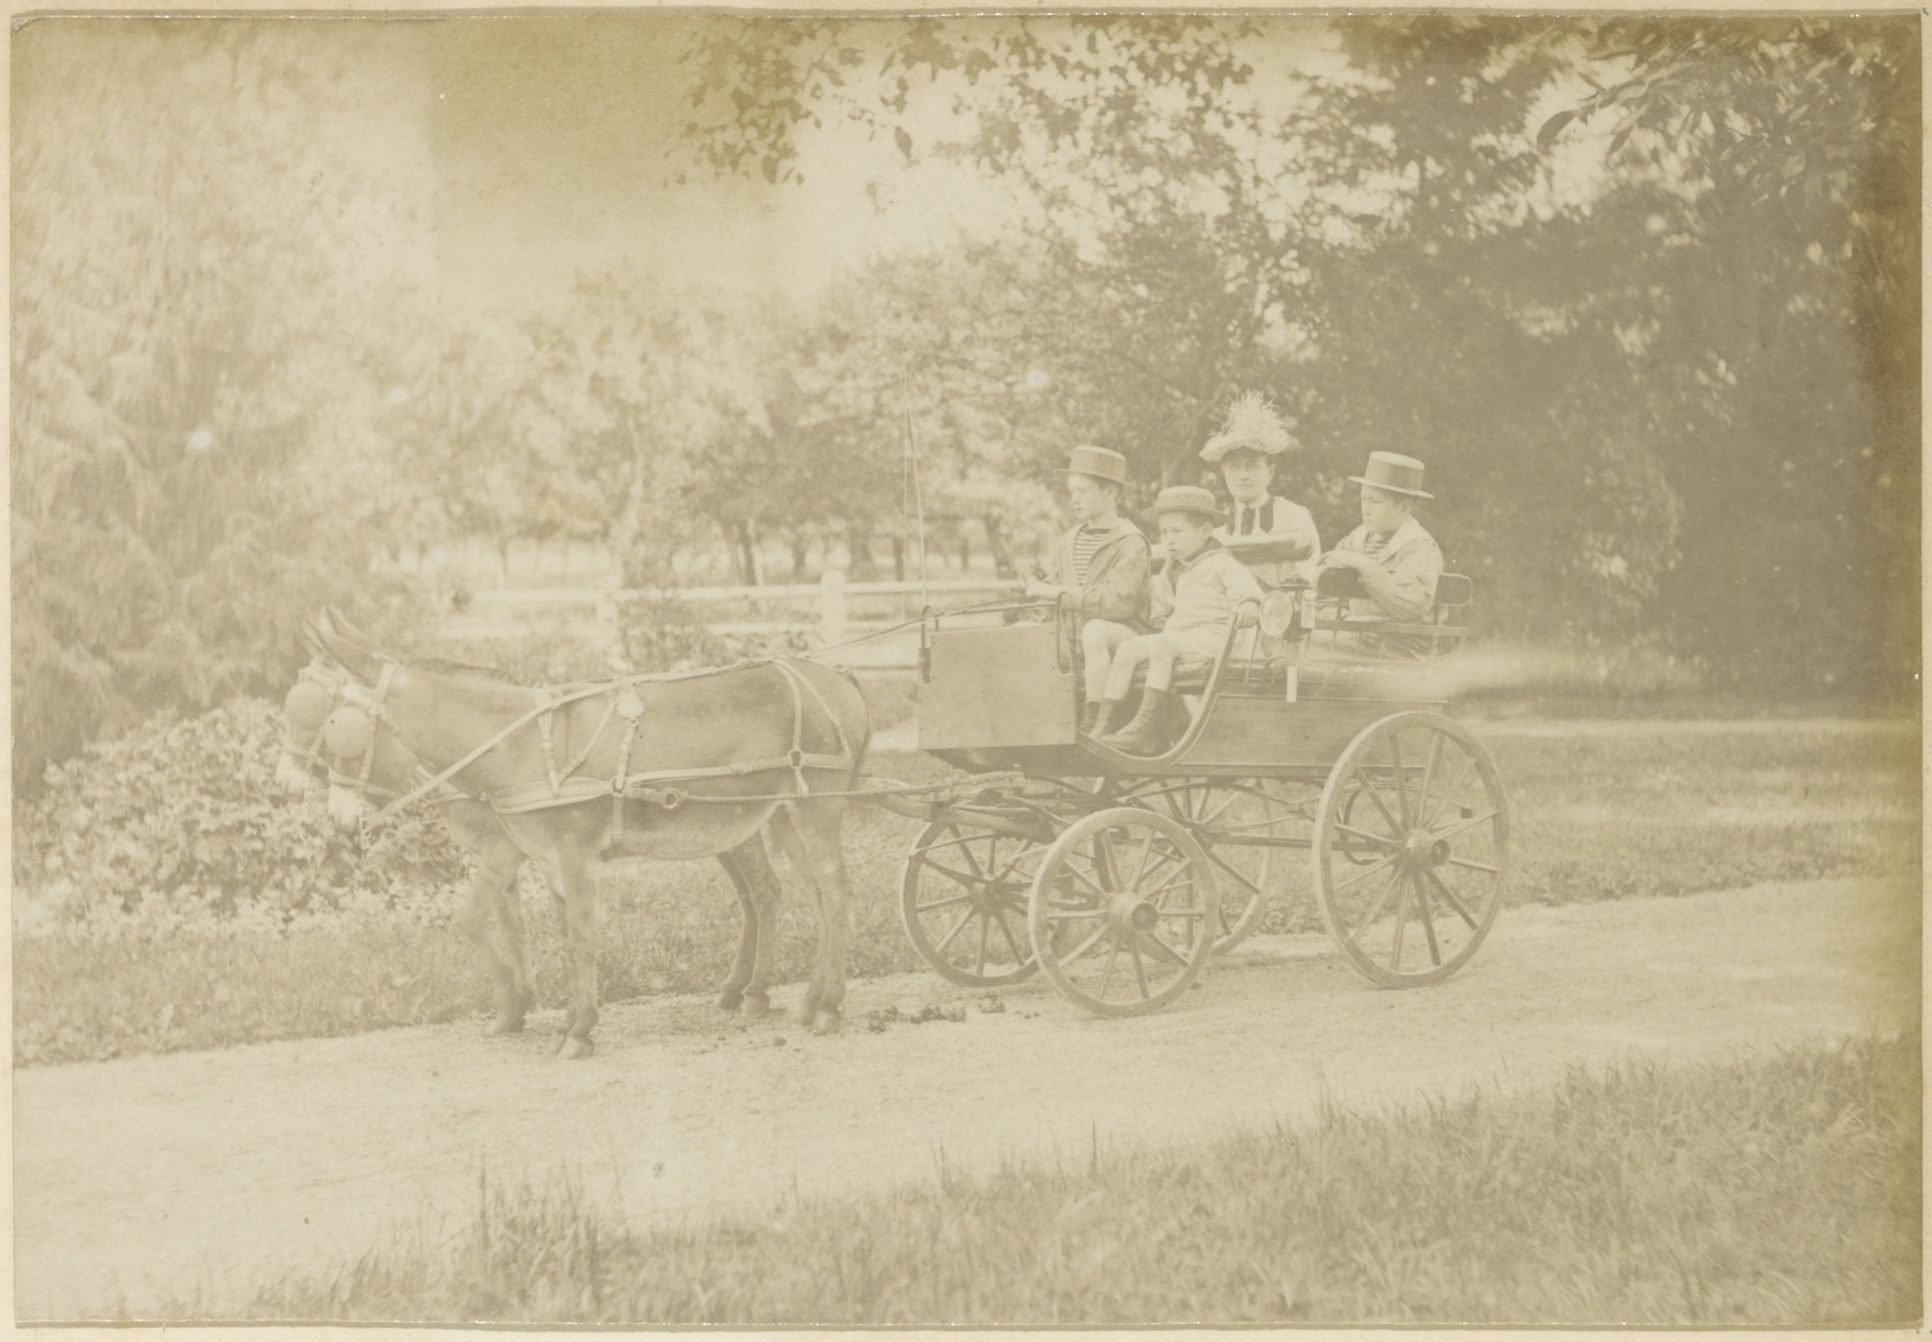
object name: photograph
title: Gezin in een rijtuig met ezels in Frankrijk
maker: Anonymous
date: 1900-1910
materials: paper, photographic support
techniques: albumen print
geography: france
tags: parents with their children, four-wheeled, animal-drawn vehicle, e.g.: cab, carriage, coach, france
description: Onderdeel van Fotoalbum van een Franse amateurfotograaf met opnames van een familie, distilleerderij Delizy & Doistau Fils, het leger en bezienswaardigheden in Frankrijk.